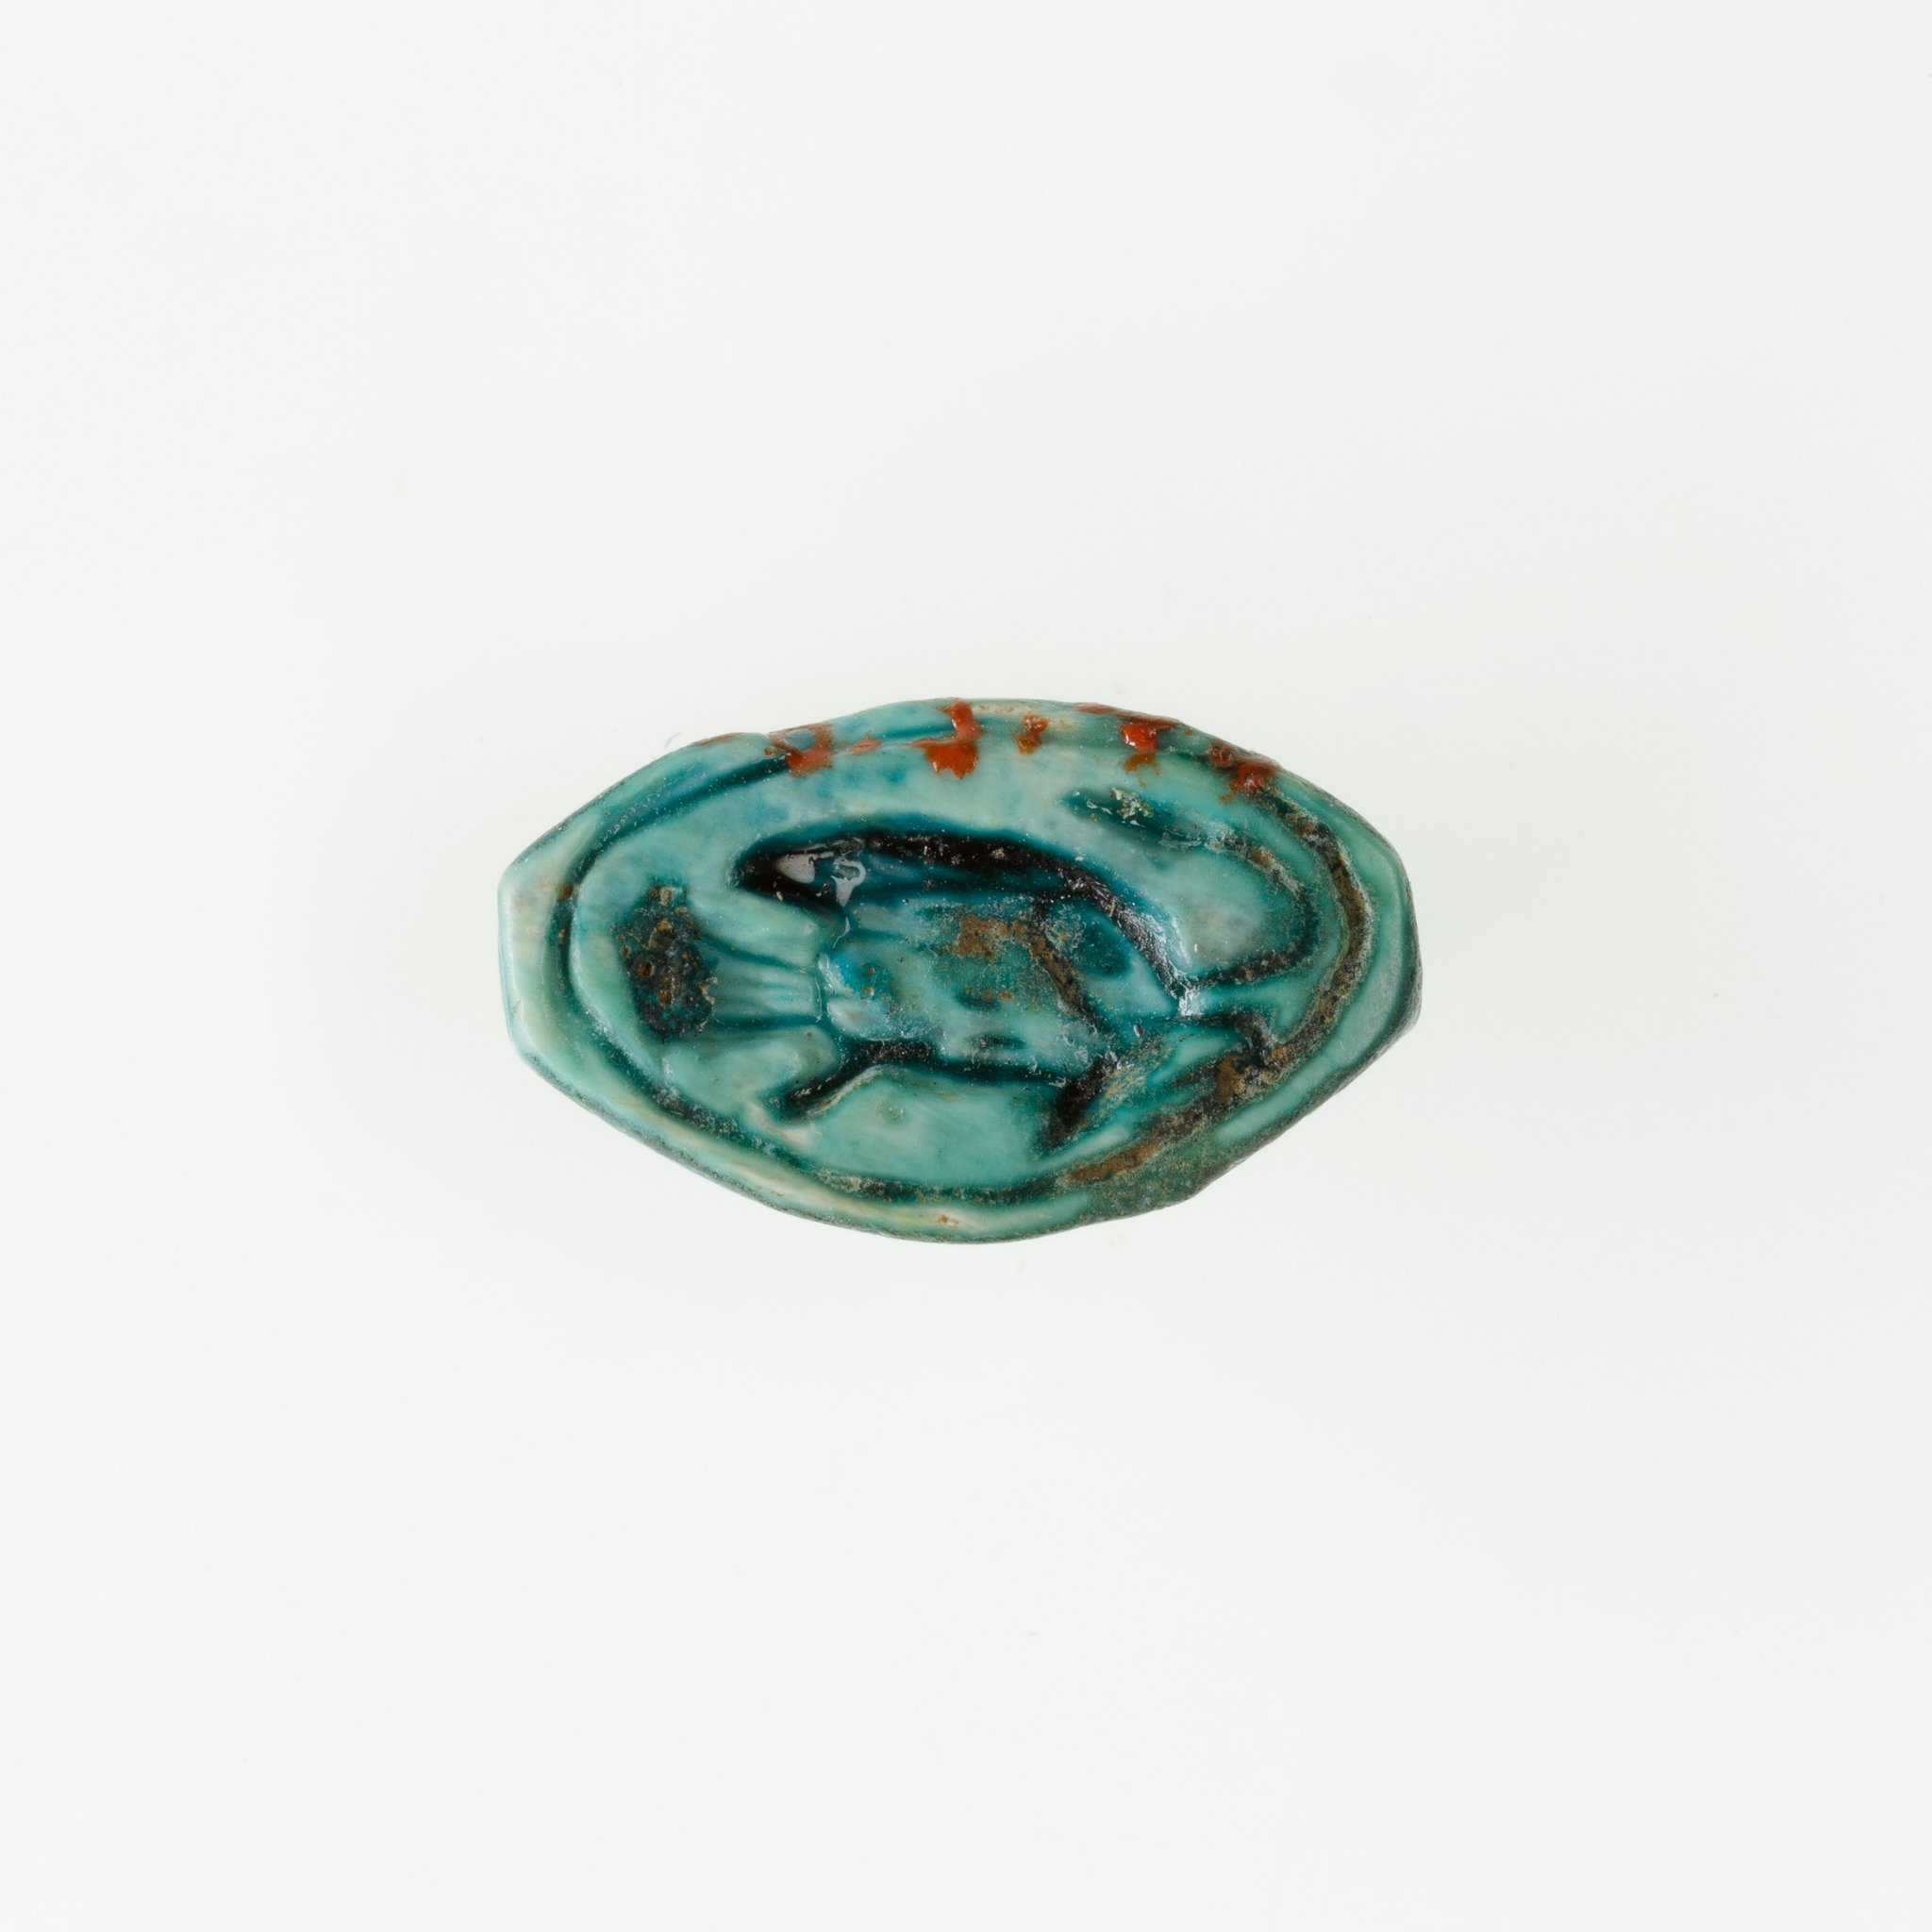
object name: cowroid, tilapia fish eating lotus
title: Cowroid Seal-Amulet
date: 1492-1473 BCE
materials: stone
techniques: glazing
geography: egypt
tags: animals